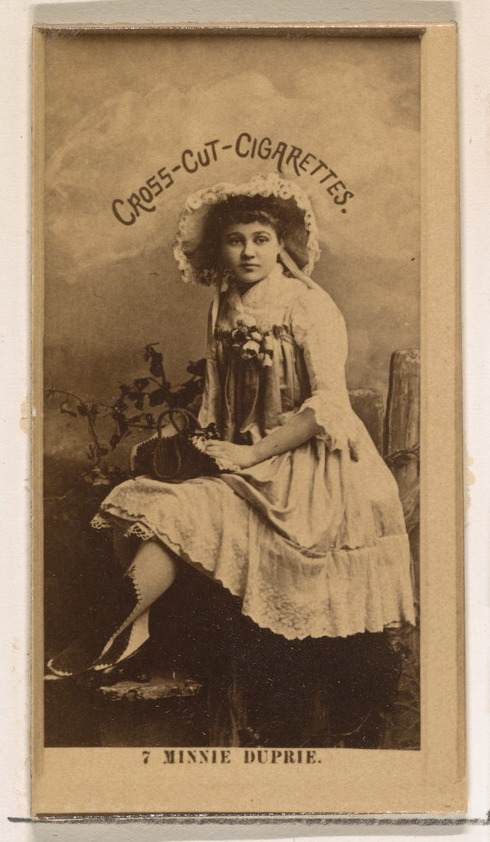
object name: print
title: Card Number 7, Minnie Dupree, from the Actors and Actresses series (N145-2) issued by Duke Sons & Co. to promote Cross Cut Cigarettes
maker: w. duke, sons & co.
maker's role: publisher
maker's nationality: american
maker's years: 1870-1920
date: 1880-1889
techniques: albumen silver print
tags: portraits,women,actresses